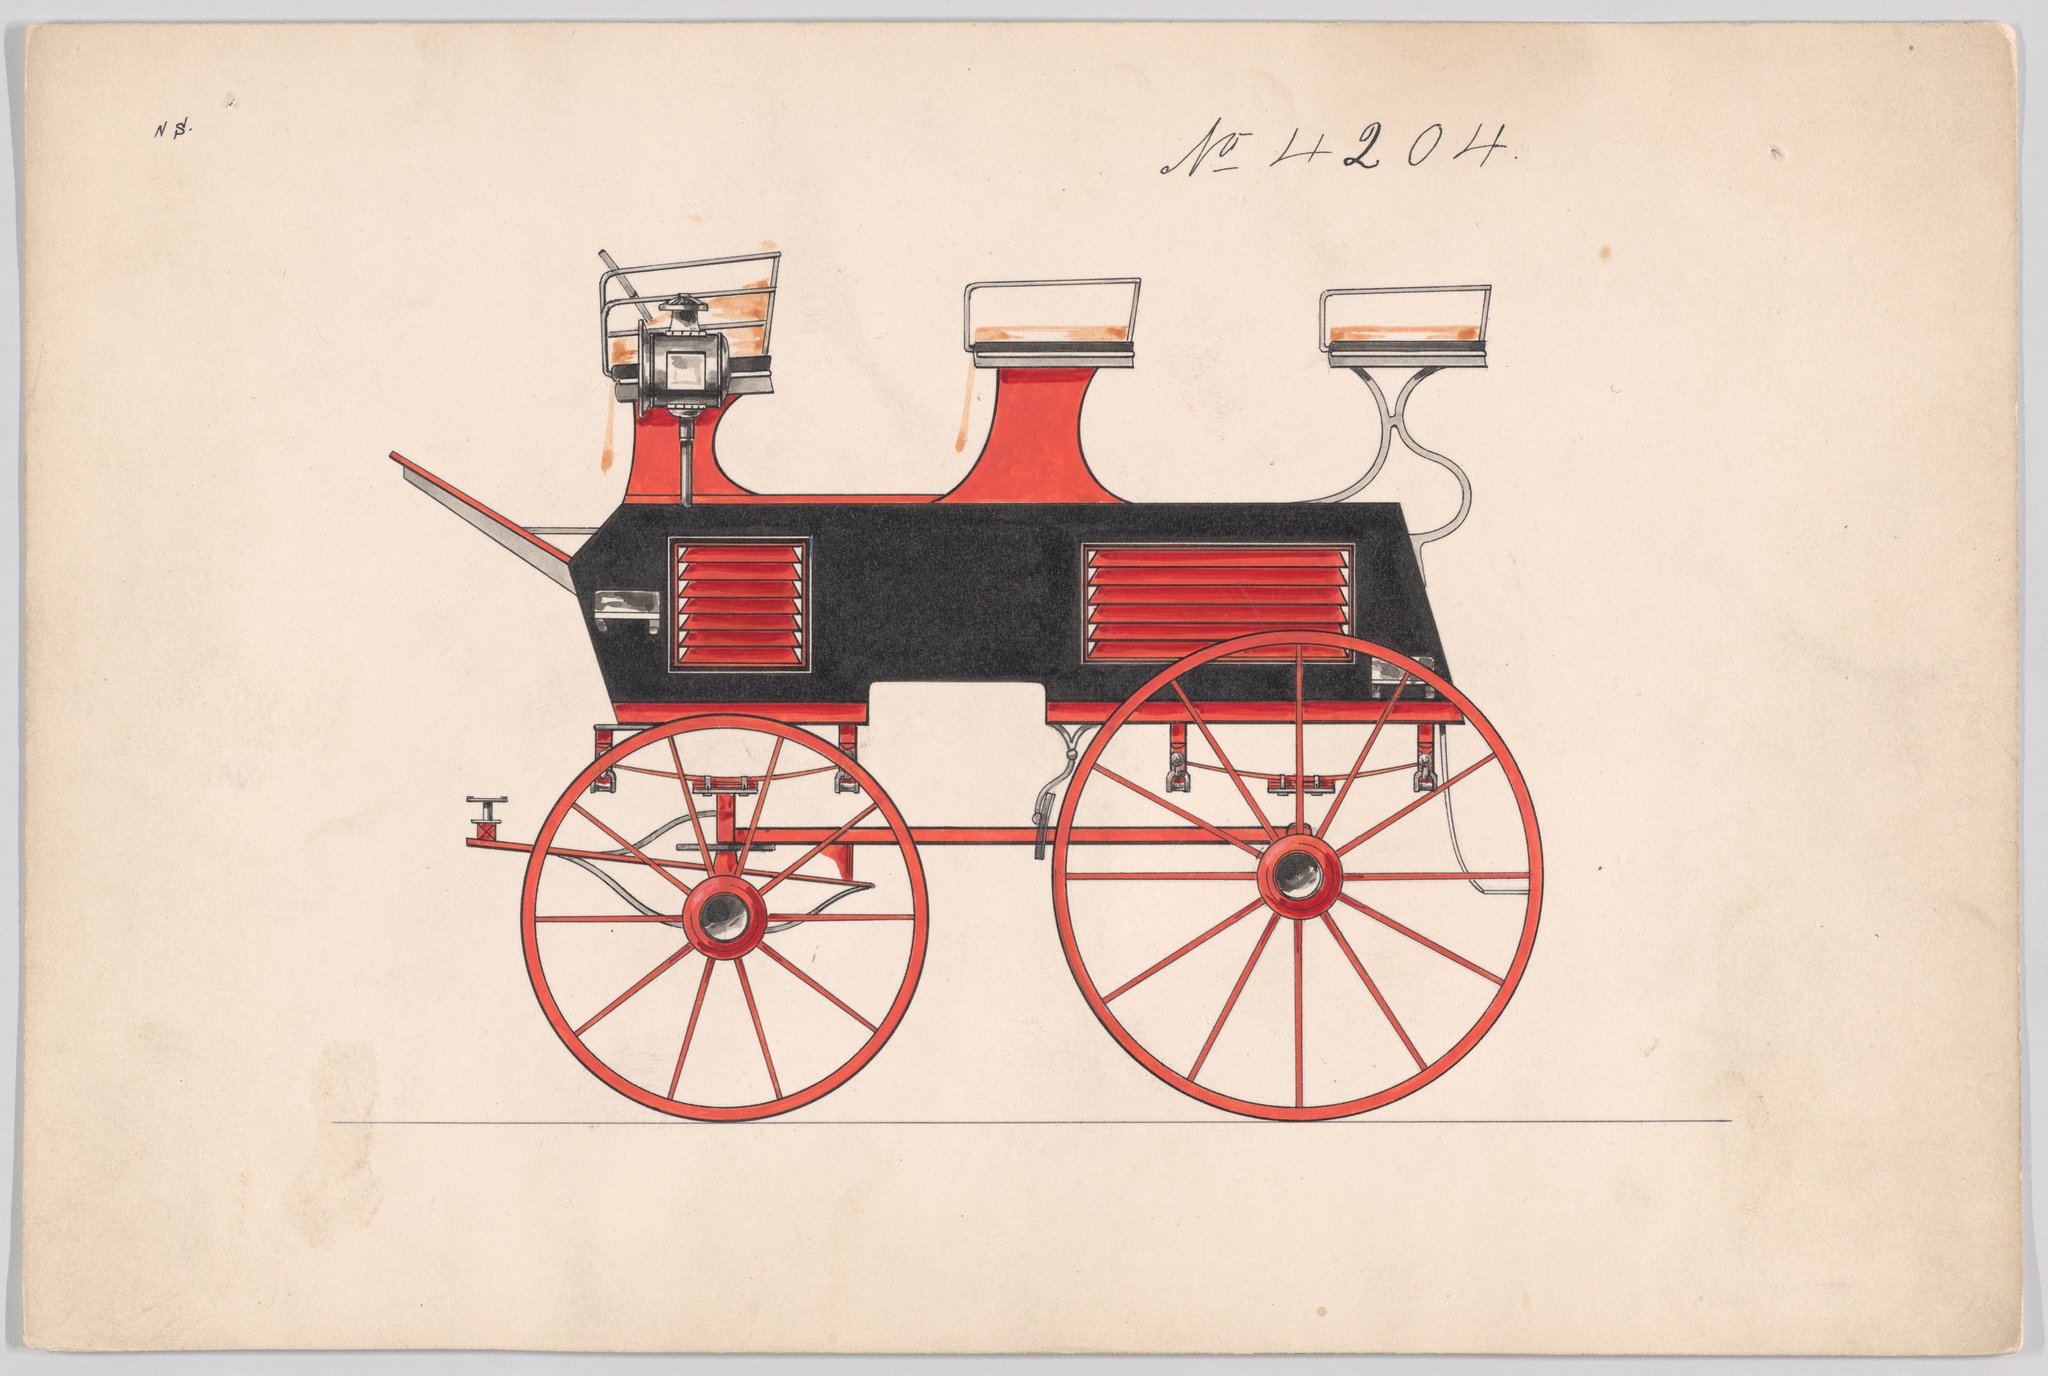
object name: drawing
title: Roof Seat Break #4204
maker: brewster & co.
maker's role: manufacturer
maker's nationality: american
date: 1893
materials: gouache, ink, watercolor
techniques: pen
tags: carriages